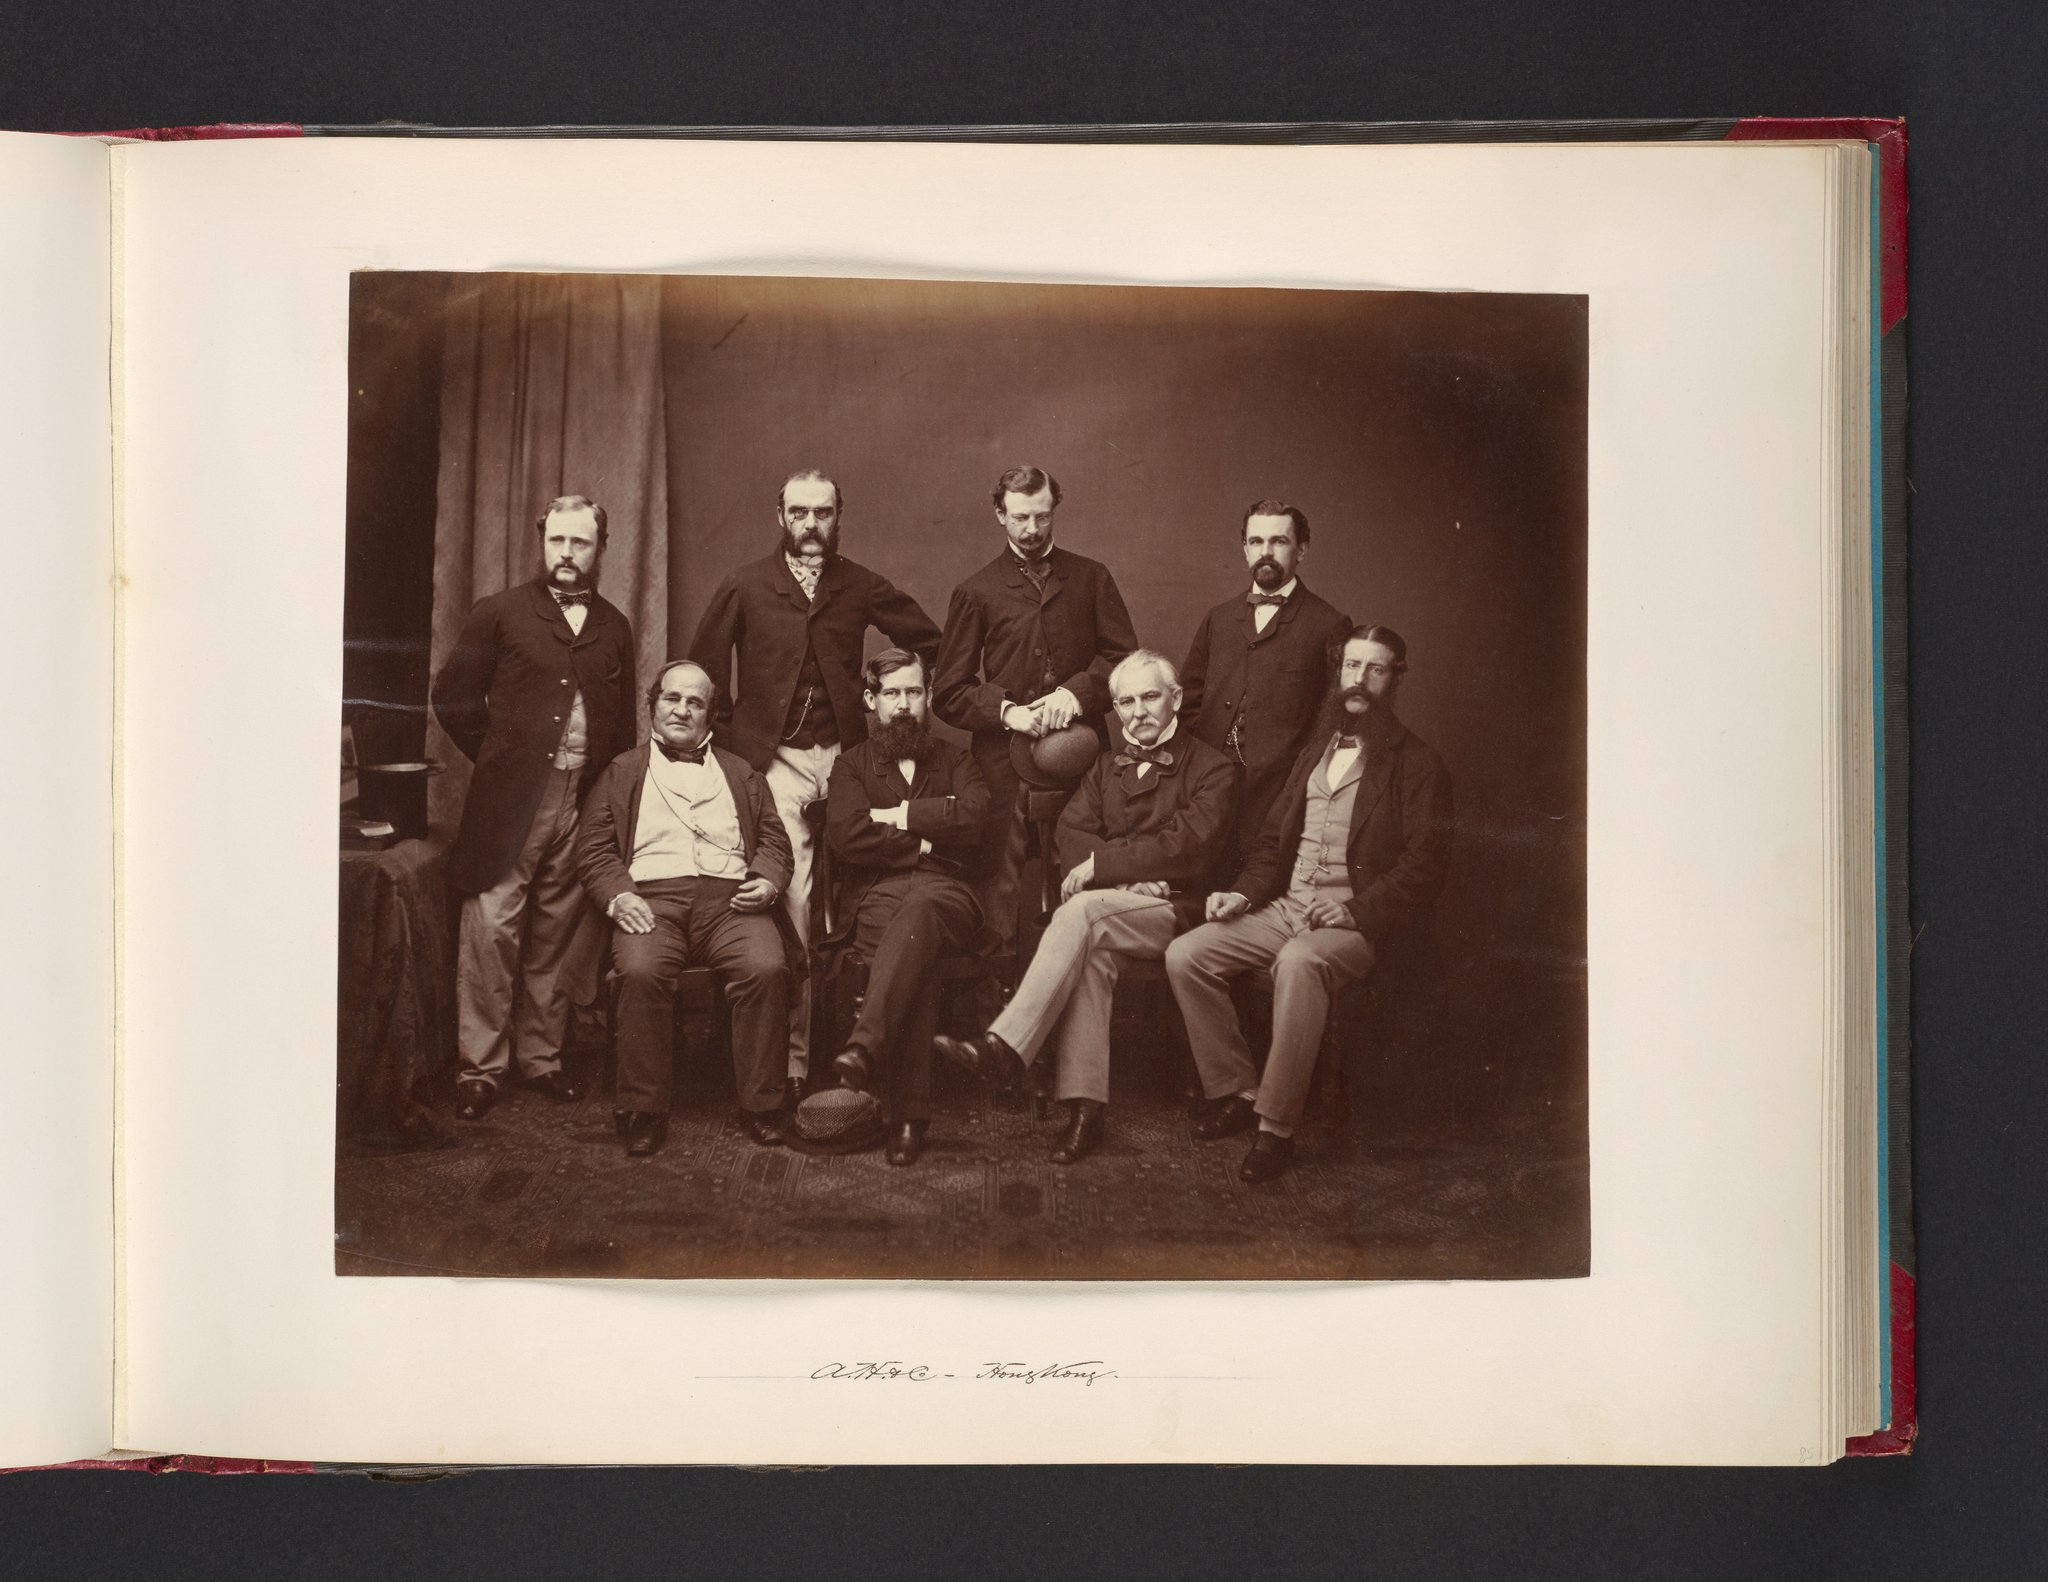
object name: photograph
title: Augustine Heard & Co. Hong Kong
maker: john thomson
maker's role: artist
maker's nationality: british, scottish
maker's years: 1837-1921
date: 1865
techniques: albumen silver print, glass negative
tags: men,portraits